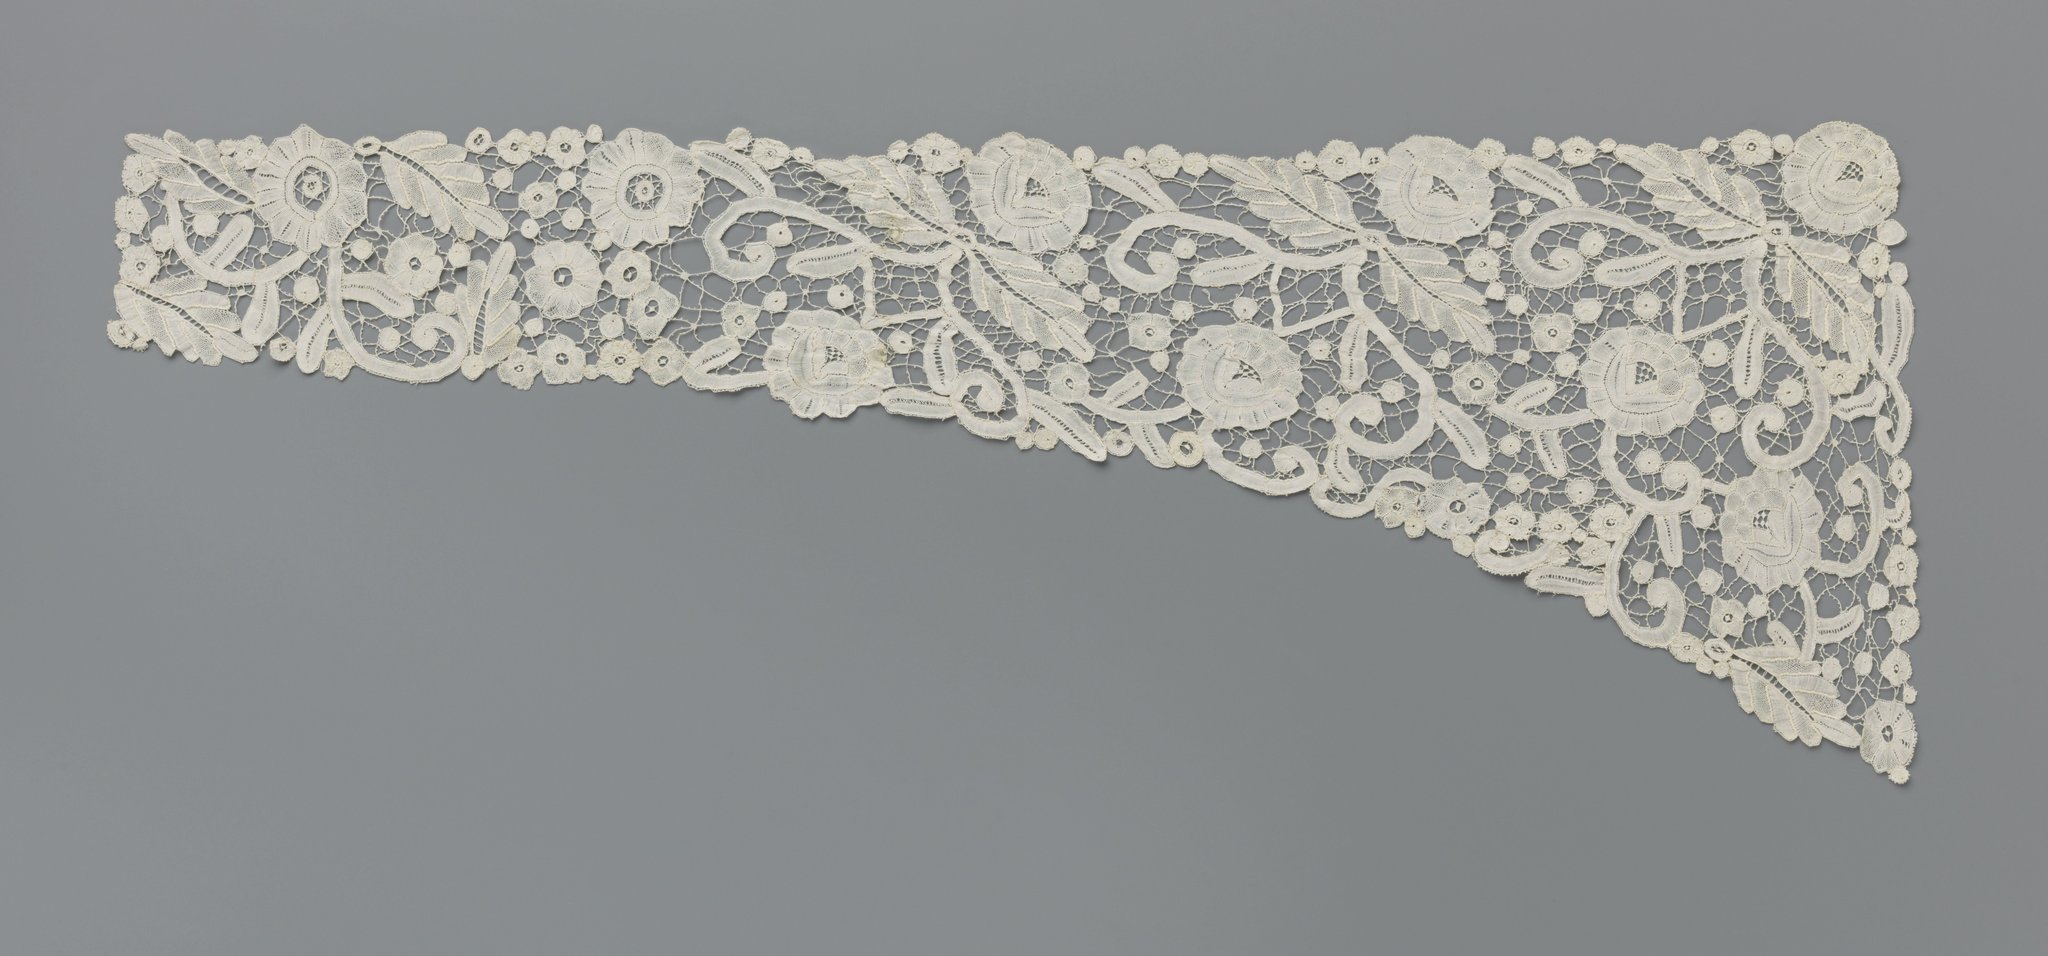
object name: sierstuk, sierobject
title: Sierstuk voor een avondmantel van gemengde kant met rozenhaag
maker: martha berkers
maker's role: kantwerkster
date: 1915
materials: linen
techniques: lace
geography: sluis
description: Sierstuk voor een avondmantel van naturelkleurige gemengde kant - kloskant in combinatie met naaldkant - Brusselse duchesse. Op een wijd gespreide vlechtengrond staan rozen die meestal op twee bladeren steunen. Een tussenornament bestaat uit enkele en dubbele voluutranken en vele kleine bloempjes.